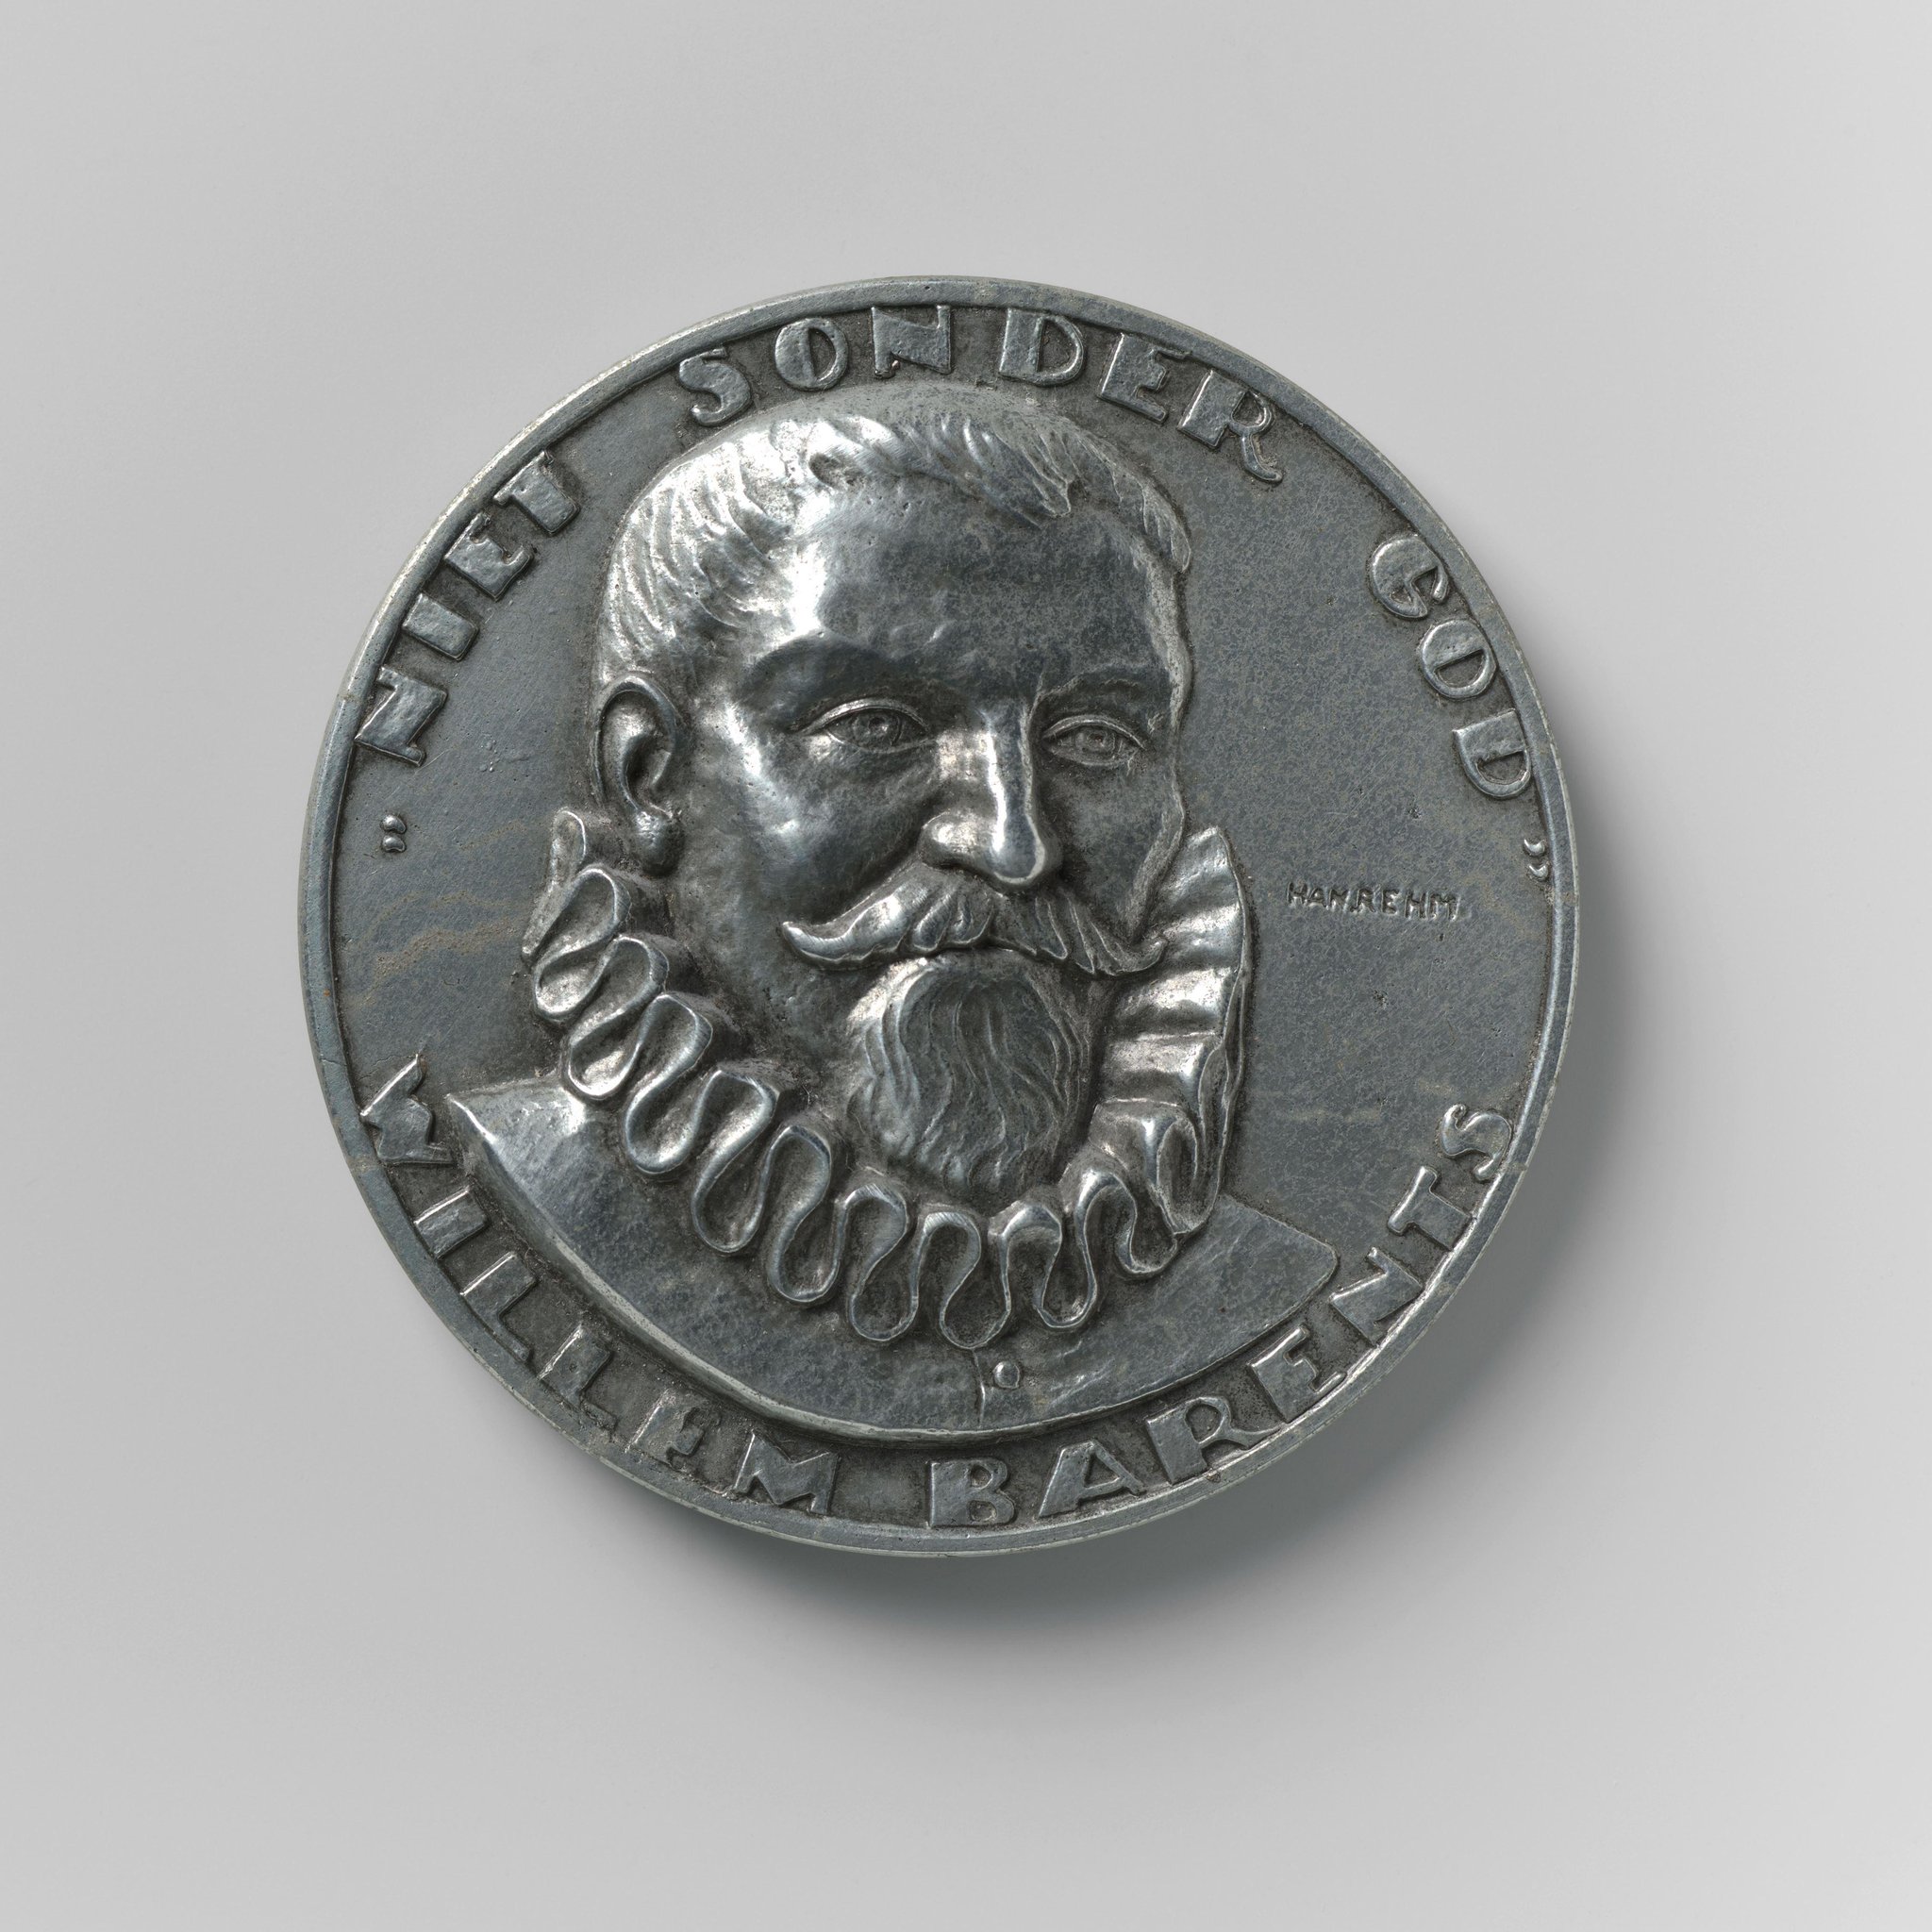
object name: history medal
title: Driehonderdvijftigjarige herdenking van de tocht naar Nova Zembla door Willem Barentsz (Vereniging voor Penningkunst 1944, jaarpenning)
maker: han rehm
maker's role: sculptor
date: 1944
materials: metal alloy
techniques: striking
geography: rotterdam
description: Witmetalen penning, op de voorzijde het bijna aanziende borstbeeld van Barents met omschrift, op de keerzijde twee mannen op een ijsschots in gevecht met een ijsbeer, met omschrift, met verklaring.